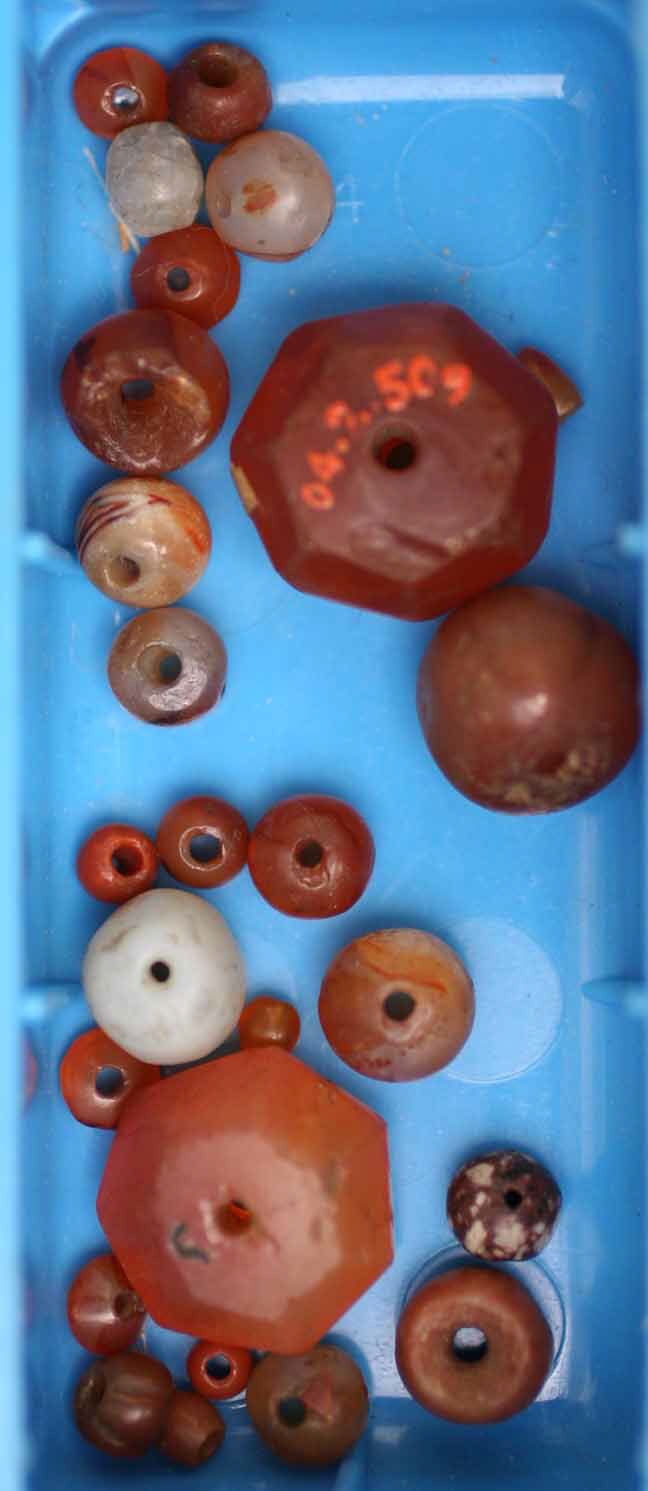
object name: bead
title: Beads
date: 201-1200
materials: stone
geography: egypt